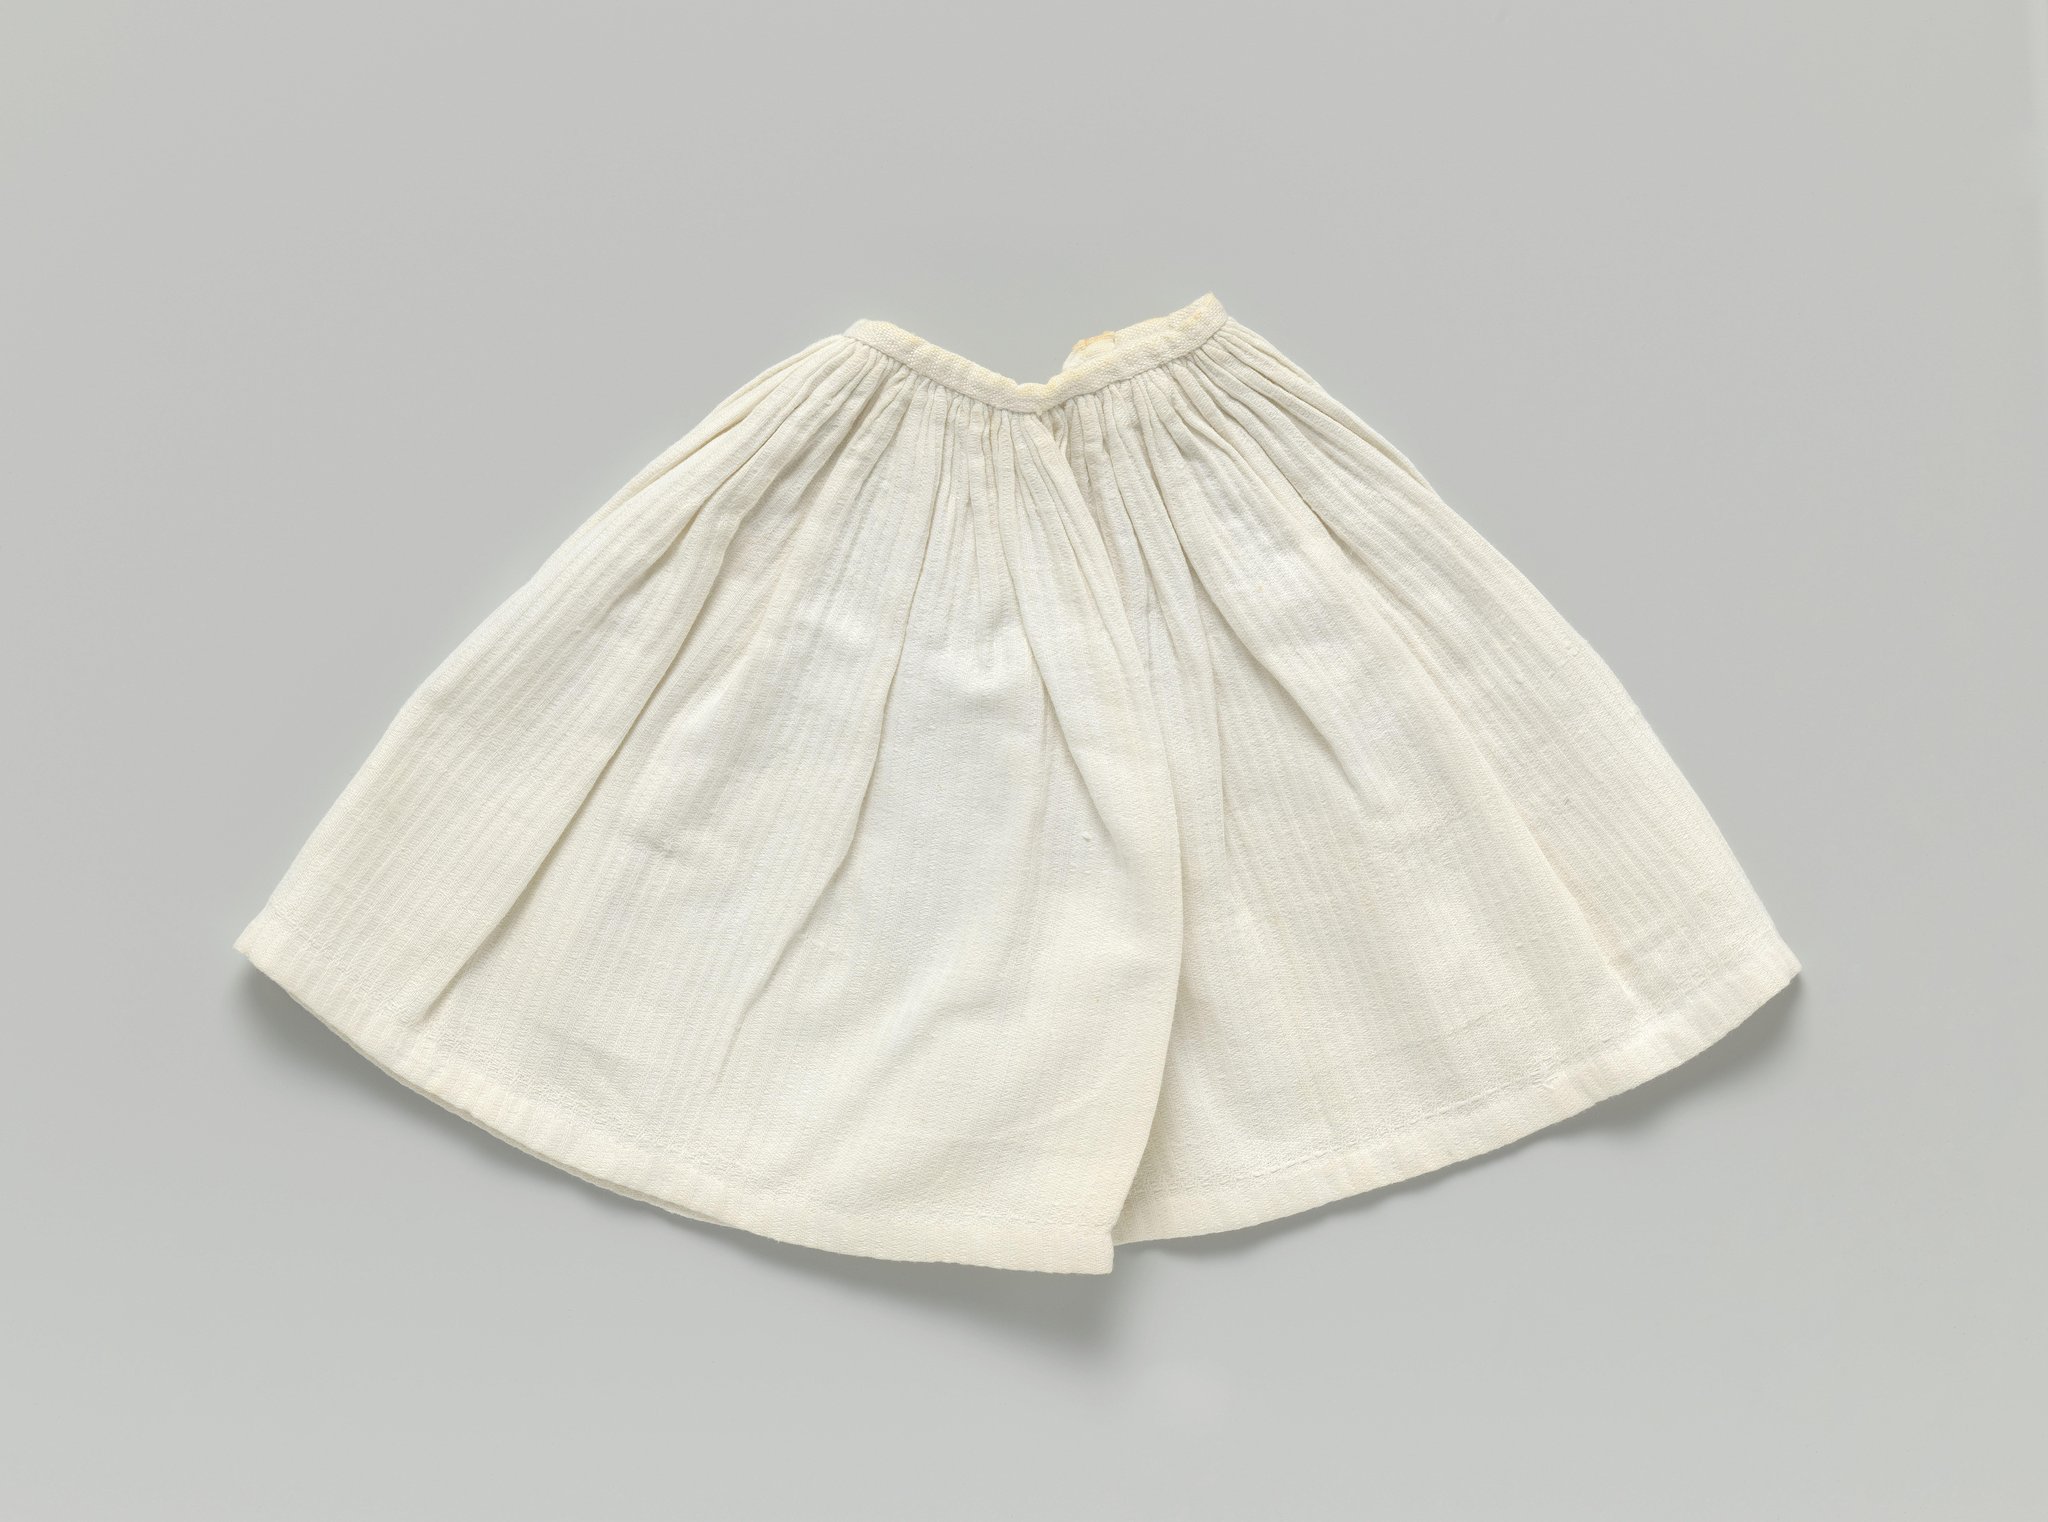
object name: underskirt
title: Onderrok met ingeweven strepen.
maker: Anonymous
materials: wool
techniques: knitting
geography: netherlands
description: Onderrok van katoen met ingeweven strepen.